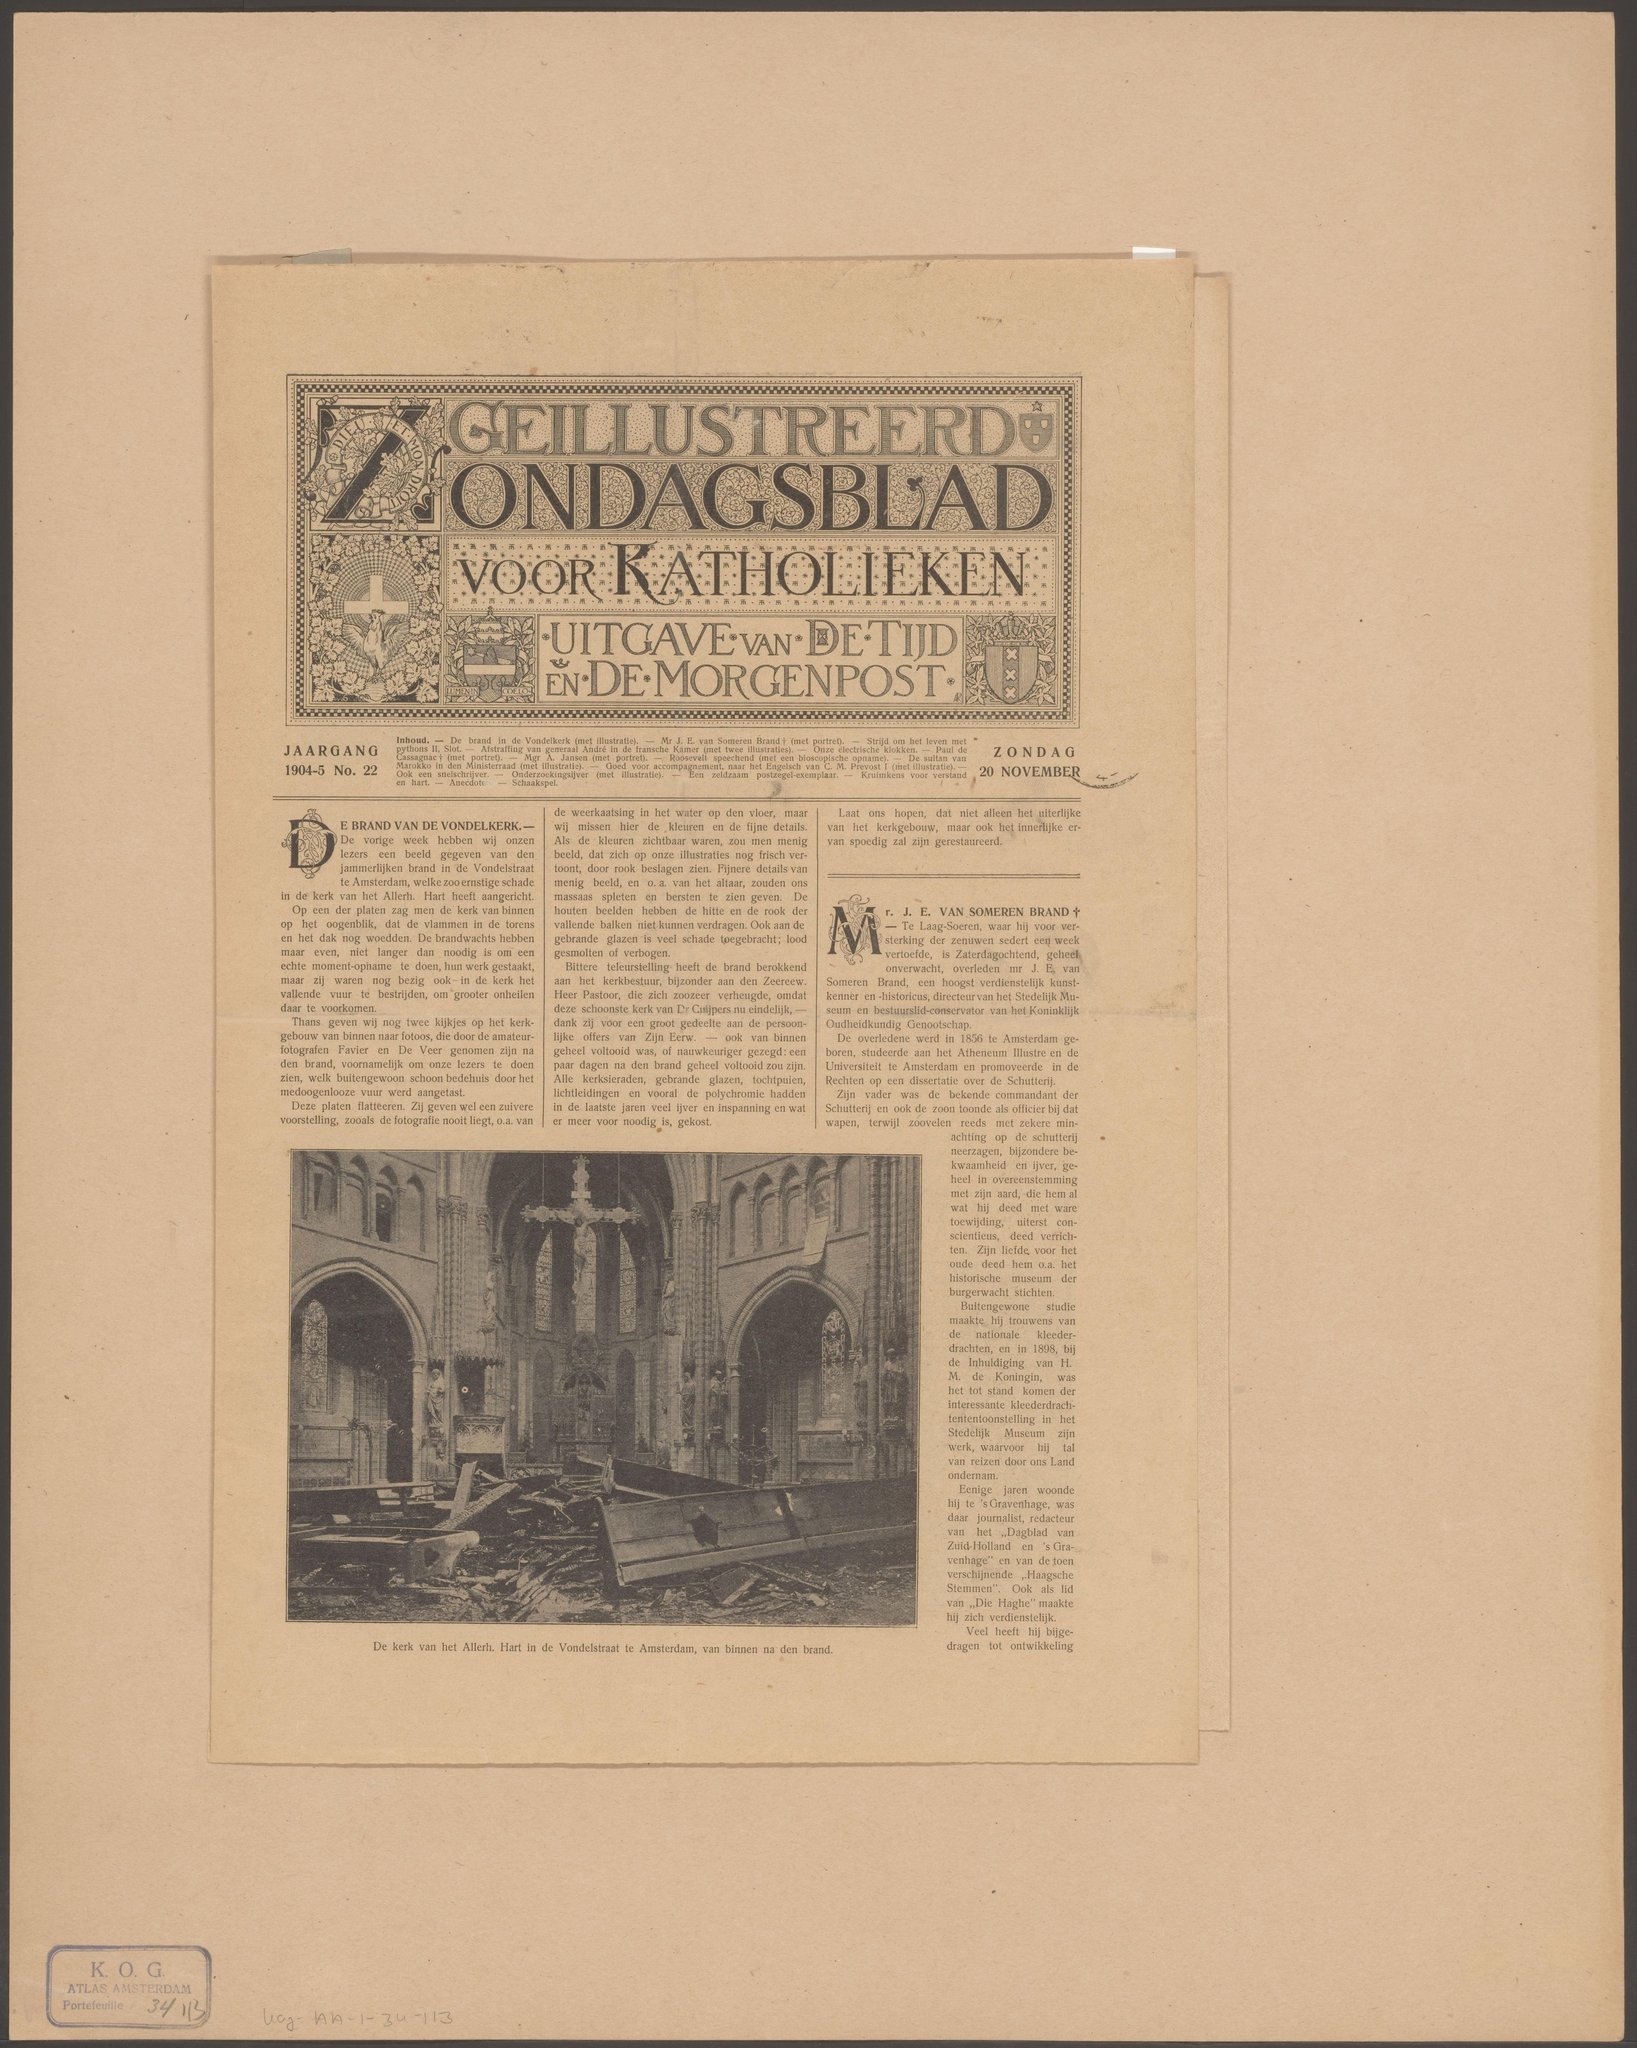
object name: photomechanical print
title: De brand van de Vondelkerk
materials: paper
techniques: letterpress printing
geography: netherlands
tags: jan eduard van someren brand, on fire, ablaze, historical persons, church (exterior), interior of church, fire-fighting, firemen, ruin of a dwelling, house, castle, etc.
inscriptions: collector's mark: Lugt 1641b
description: Object bestaat uit twee aan elkaar geplakte bladen, zeer waarschijnlijk afkomstig uit twee opeenvolgende publicaties van het Geïllustreerd Zondagsblad voor Katholieken. Op recto van het tweede blad - dat is p. 157 - zijn nog twee fotomechanische afdrukken geplakt. In totaal stellen zeven fotomechanische afdrukken de Vondelkerk voor in haar staat voor, tijdens en na de brand van 8 november 1904. Een portret van Jan Eduard van Someren Brand op p. 162 is niet gerelateerd aan de rest. Onderwerpsrubriek binnen de Atlas Amsterdam: Kerkwezen: R.K. Gemeenten: Begijnhof t/m Petrus en Paulus.